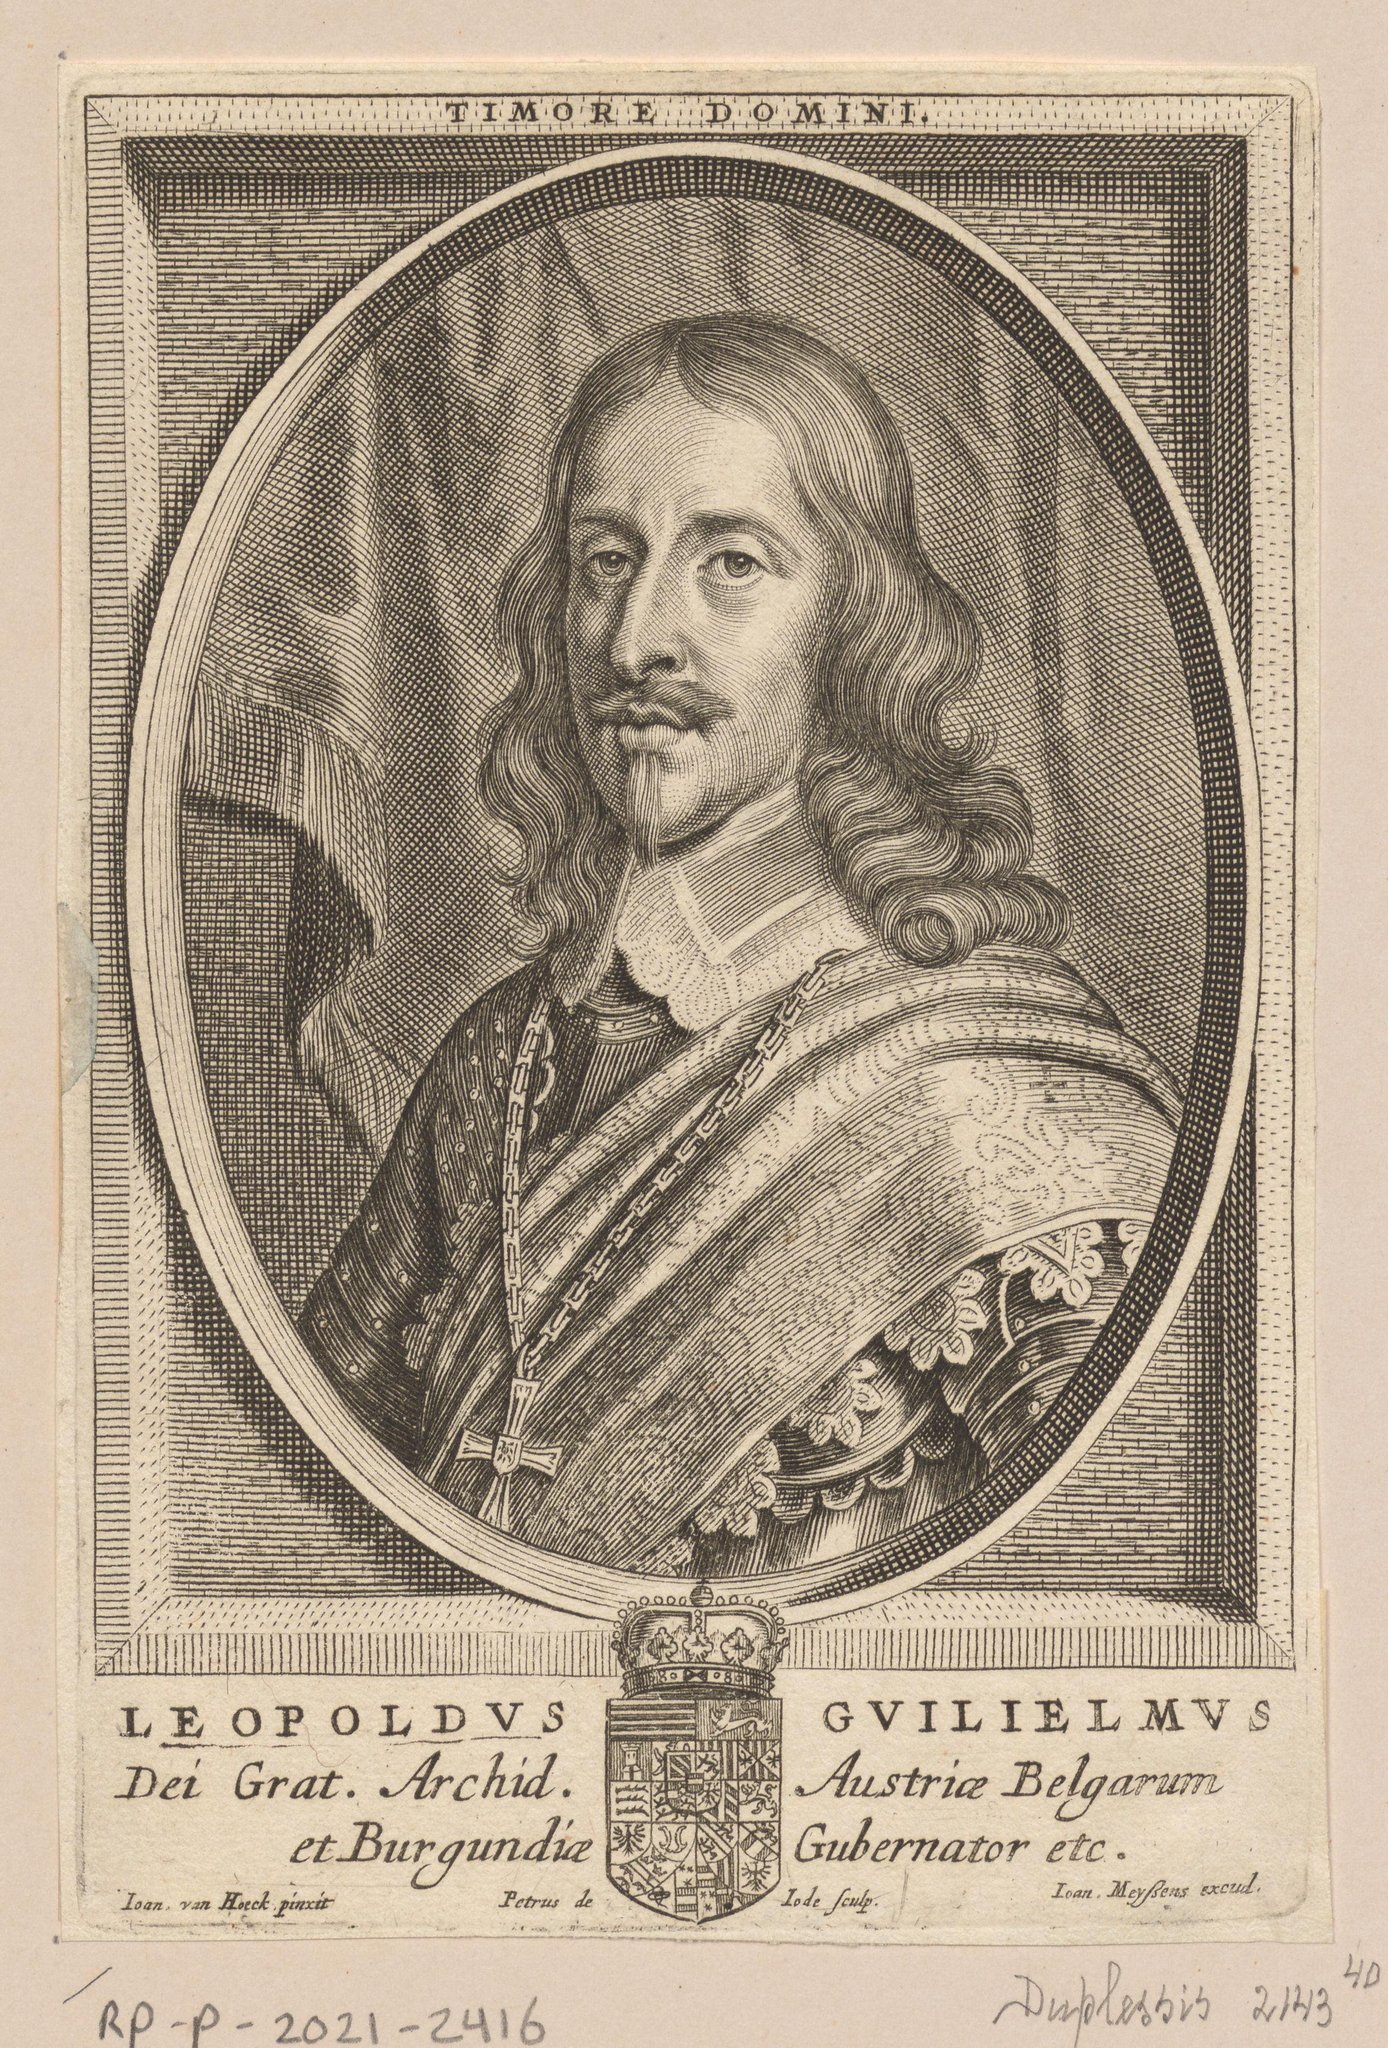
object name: print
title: Portret van Leopold Willem van Oostenrijk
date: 1647-1662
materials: paper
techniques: engraving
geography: antwerp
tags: vienna, leopold willem van oostenrijk (landvoogd der zuidelijke nederlanden), ornament ~ medallion, armour, historical persons, crucifix ~ personal devotion, armorial bearing, heraldry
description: Met onderschrift in het Latijn. Met bovenin zijn motto 'Timore Domini'.